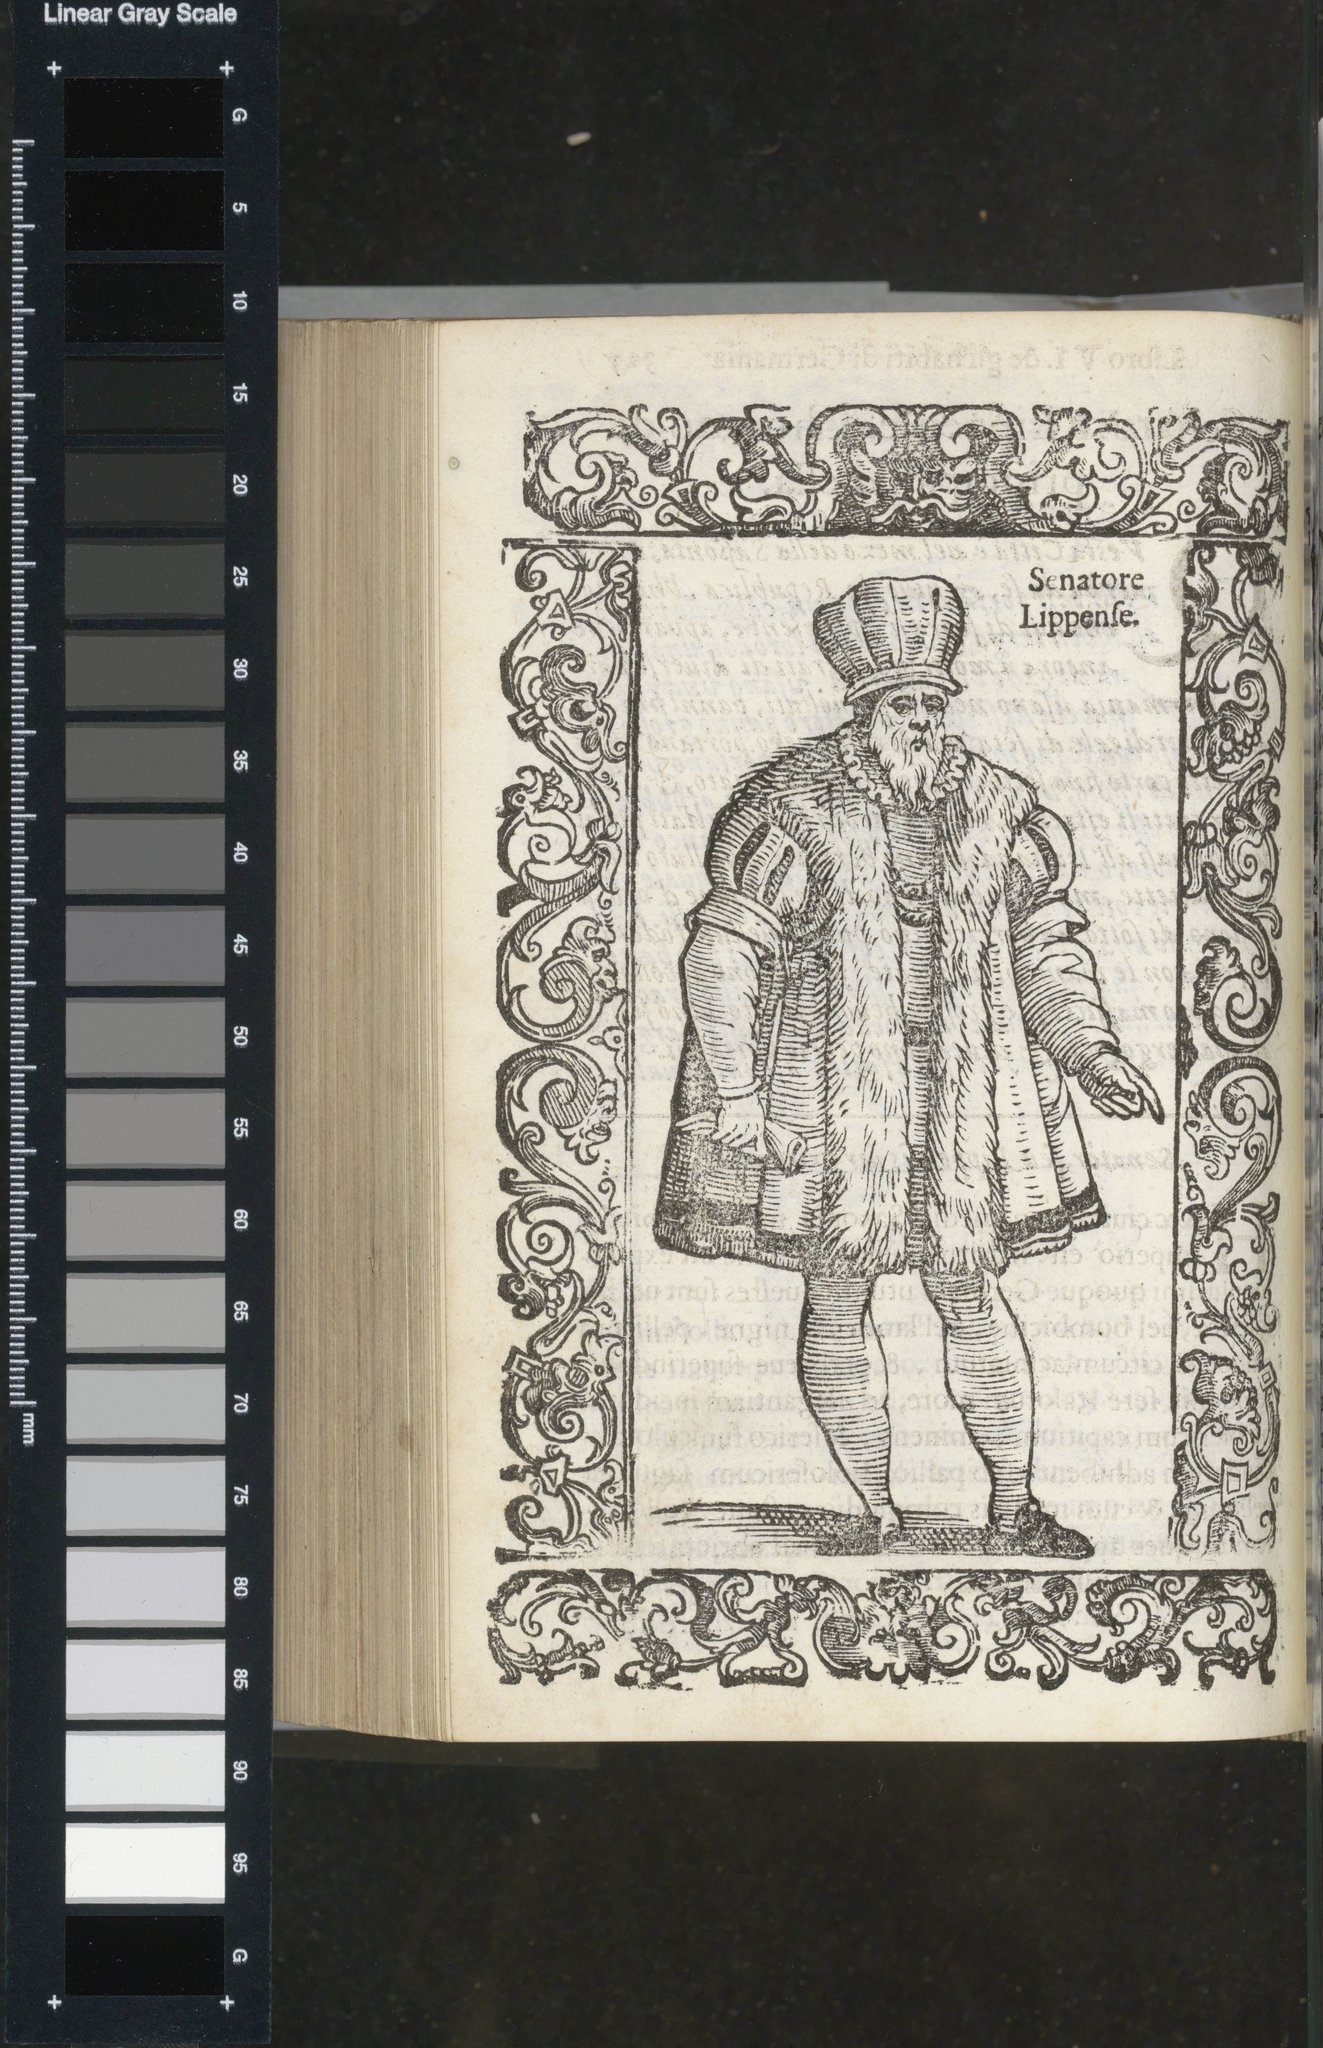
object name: costume print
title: Habiti antichi, et moderni di tutto il mondo...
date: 1598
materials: paper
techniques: woodcut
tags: fashion plates